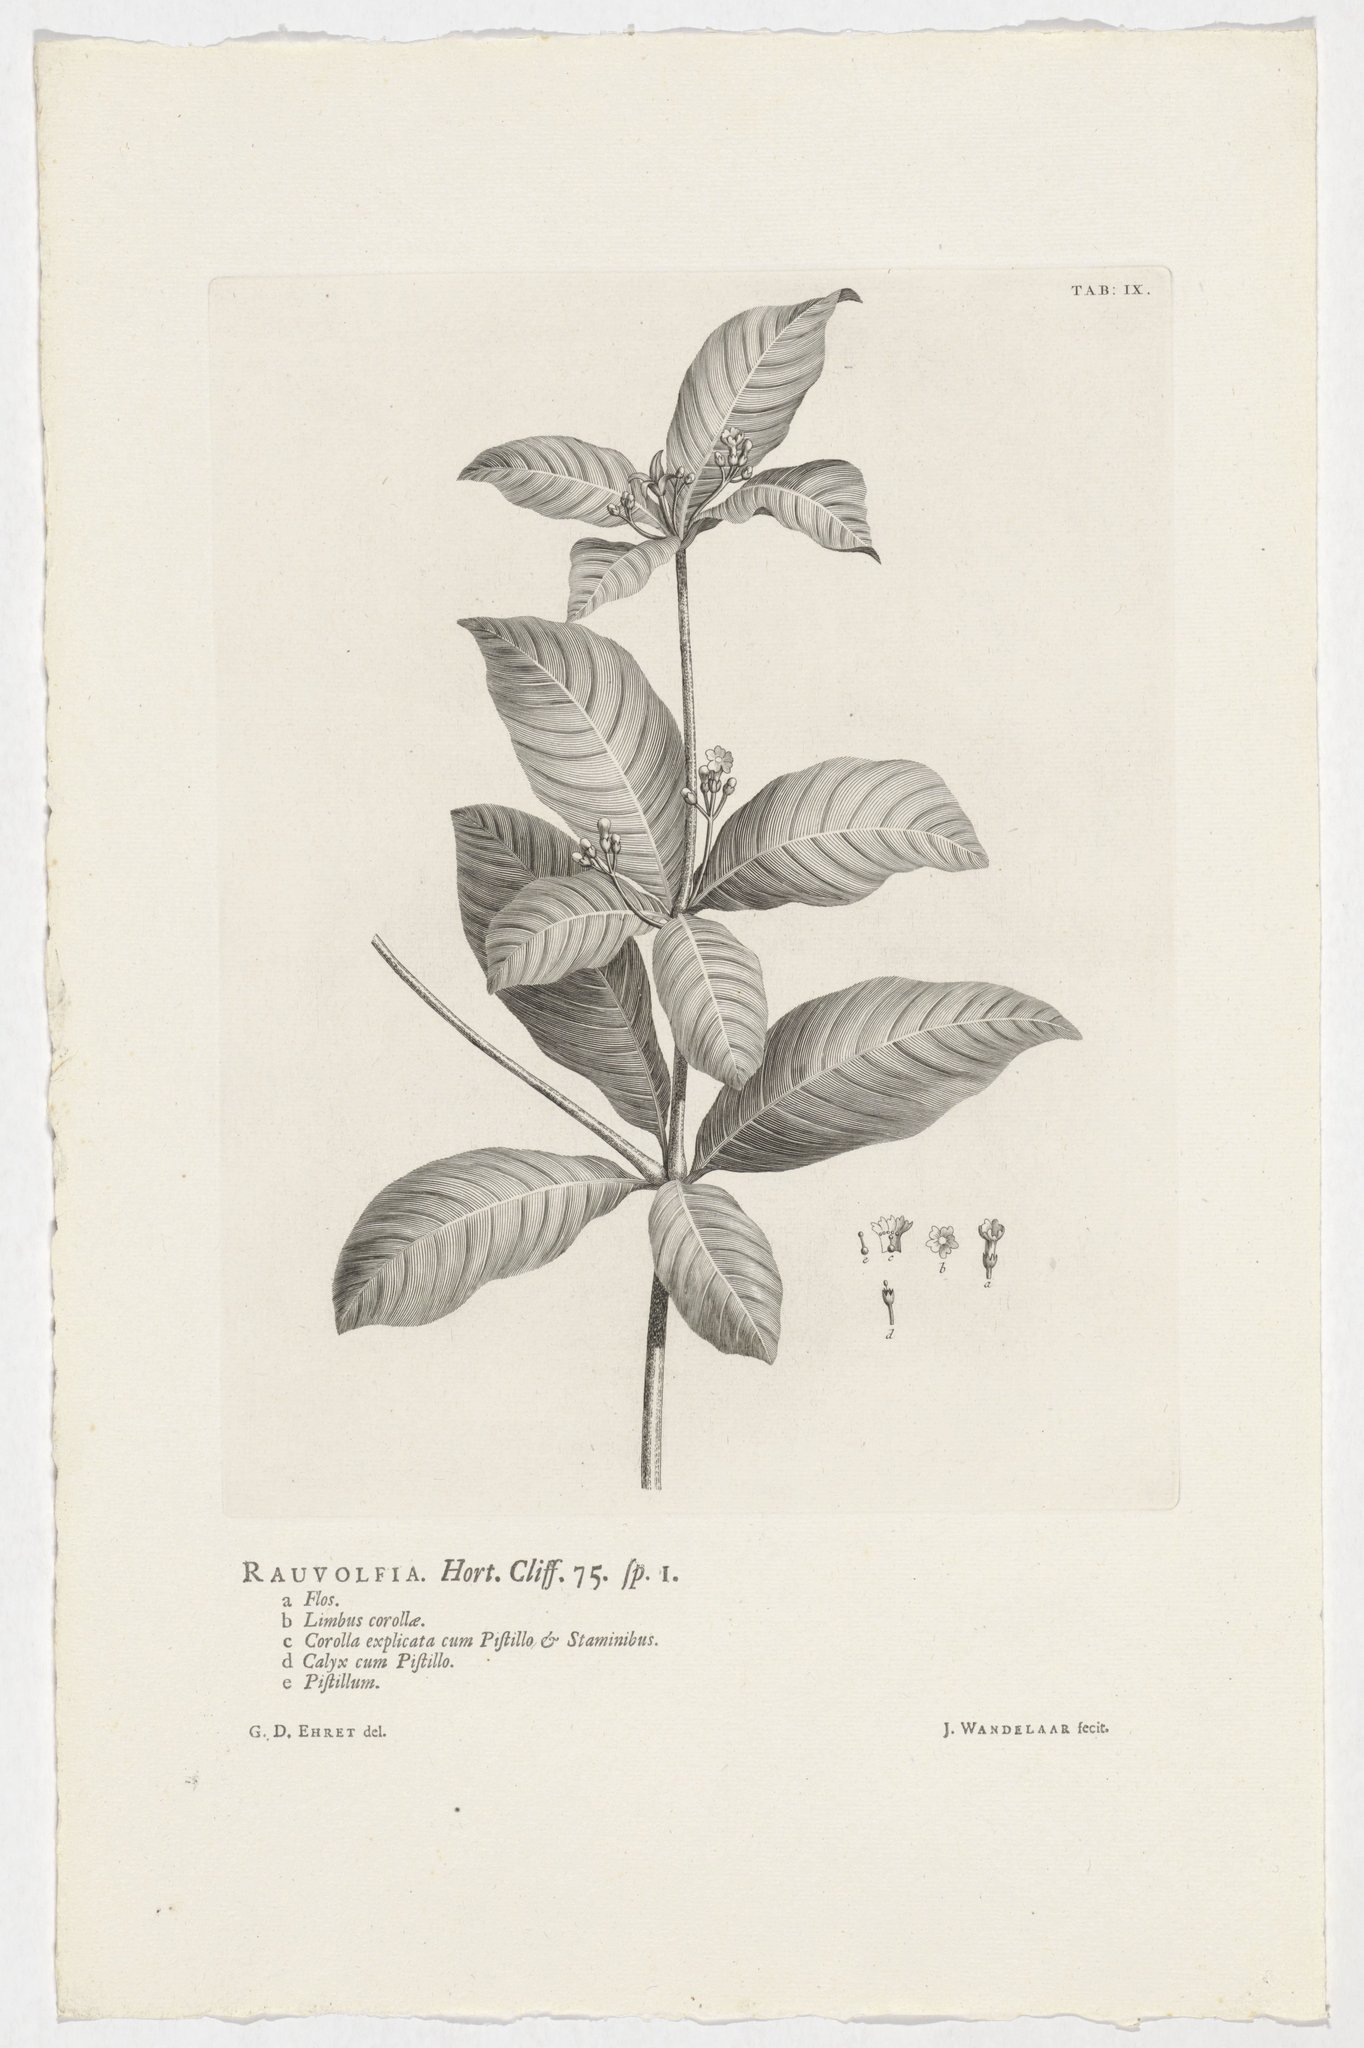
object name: book illustration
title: Rauvolfia tetraphylla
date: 1738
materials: paper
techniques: etching, letterpress printing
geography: warmond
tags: flowers, plants and herbs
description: Prent gebruikt als illustratie in: Linnaeus, Carolus. Hortus Cliffortianus plantas exhibens quas in hortis tam vivis quam siccis, Hartecampi in Hollandia, coluit (...) Georgius Clifford. Amsterdam: sine nomen, 1738.